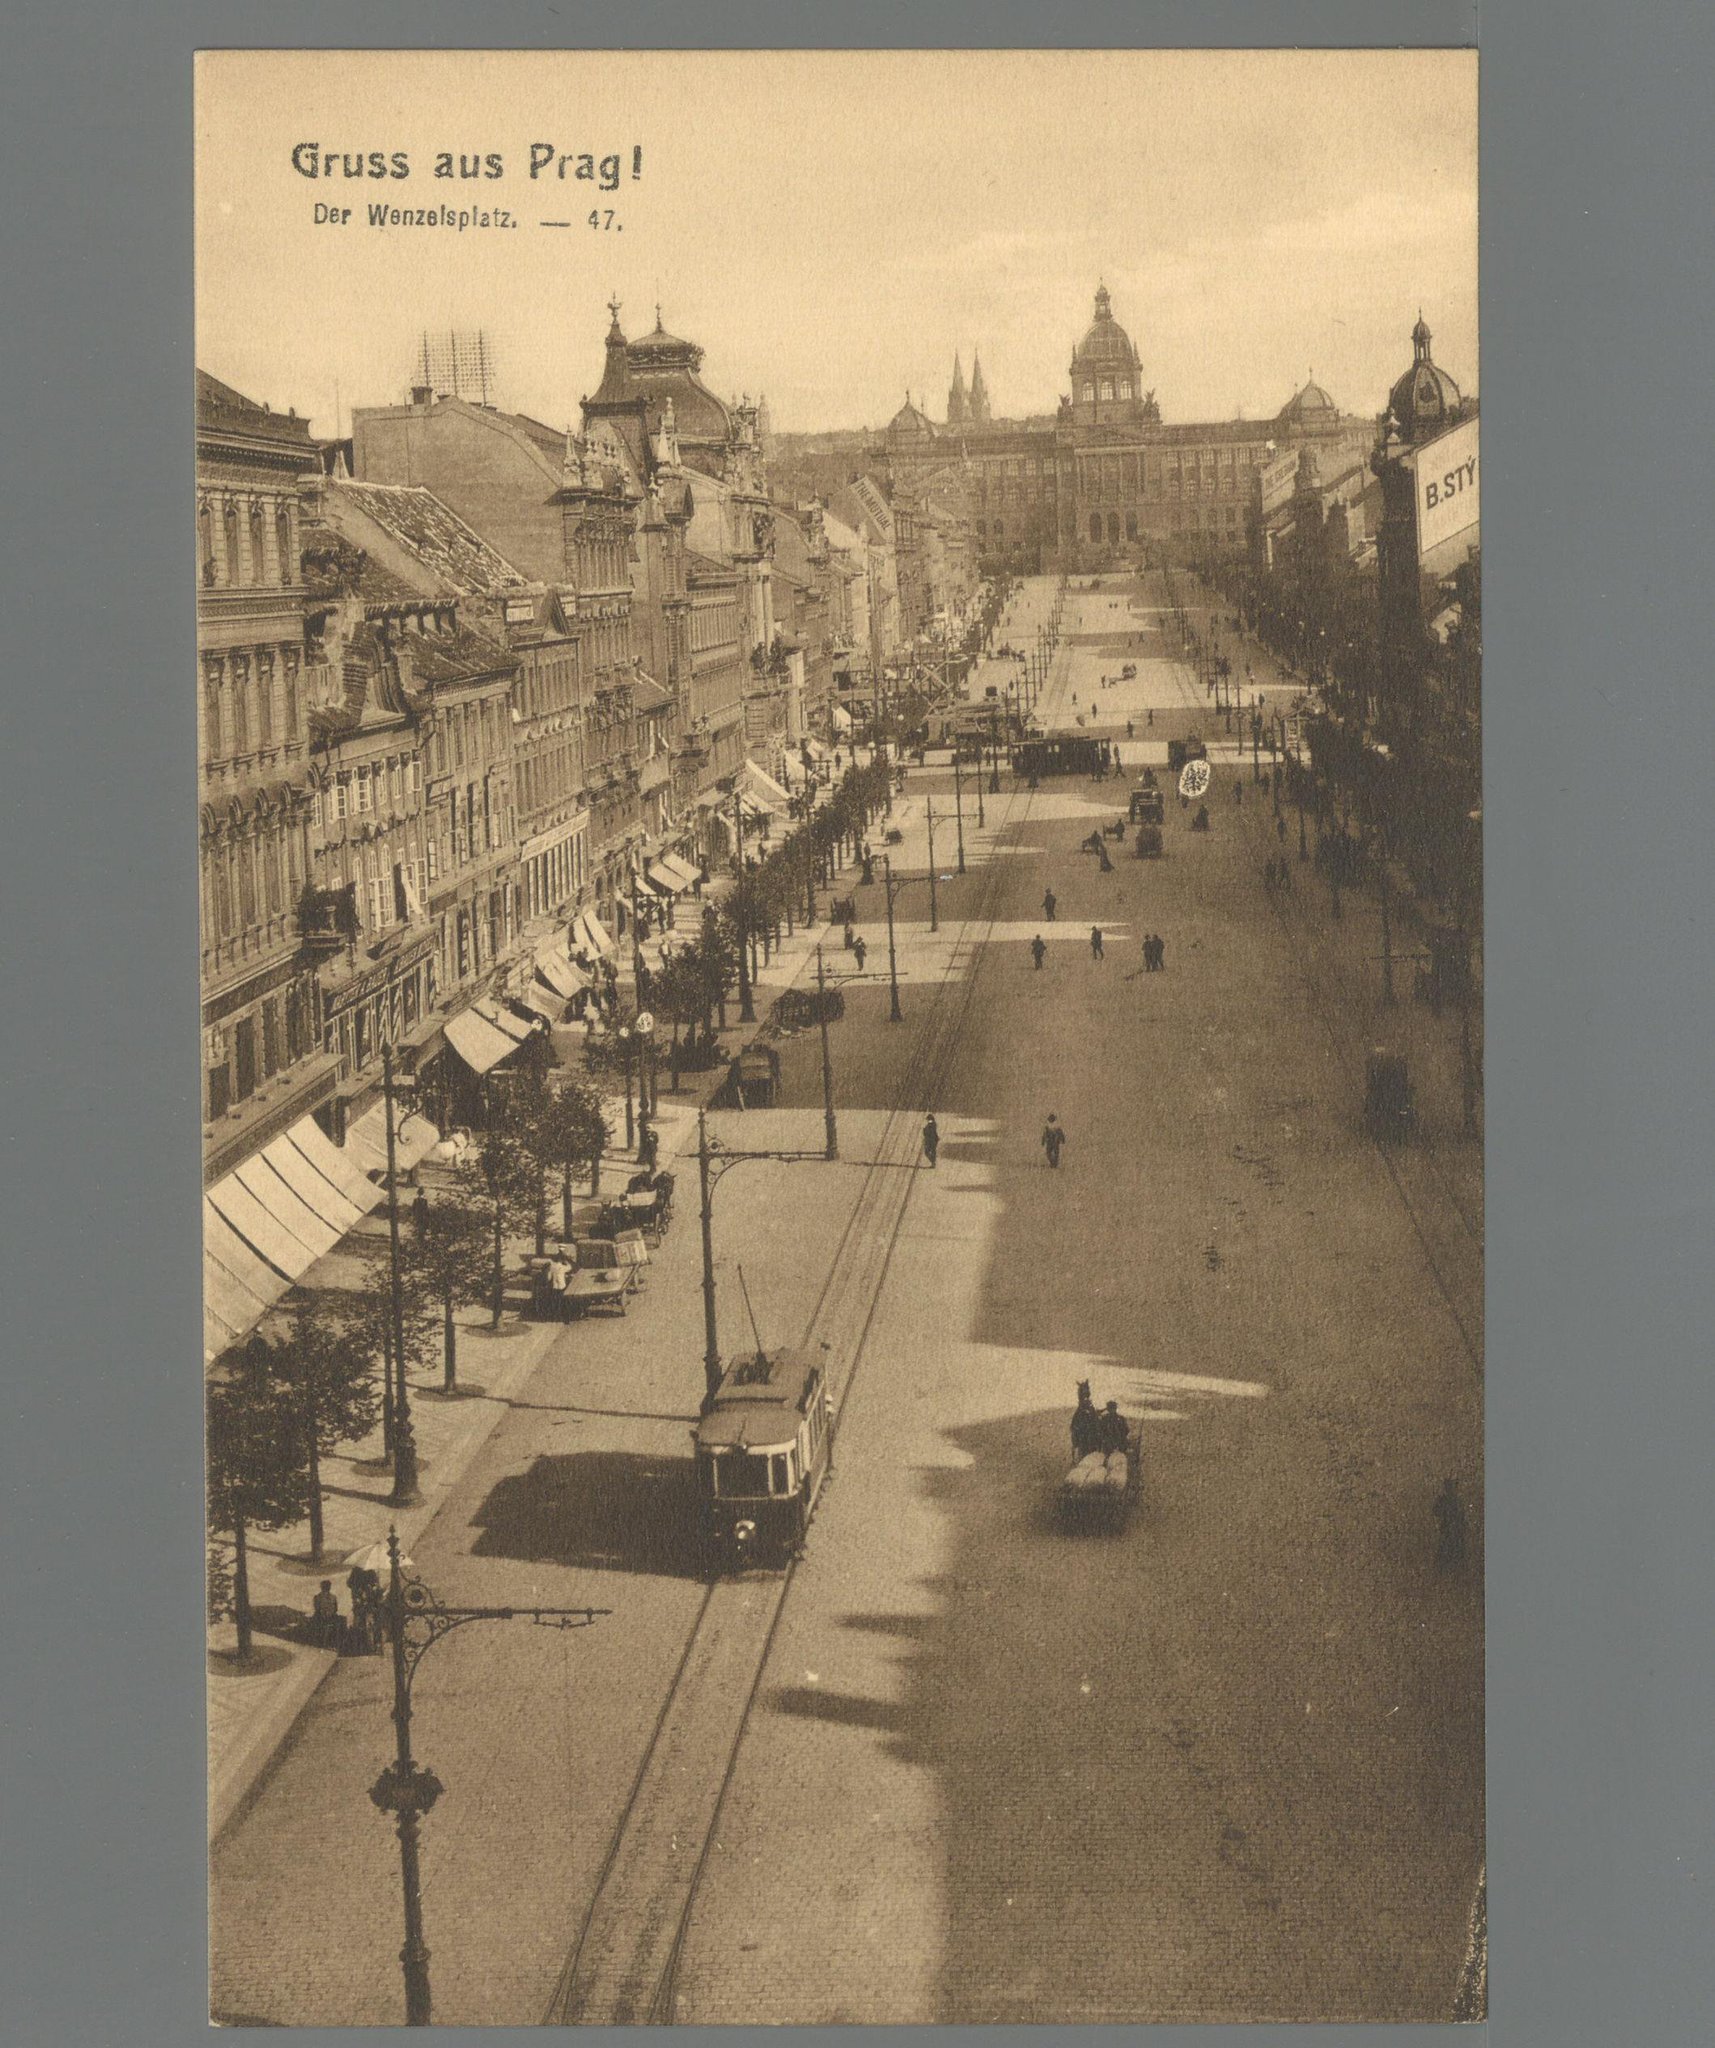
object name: ansichtkaart, prentbriefkaart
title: Gruss aus Prag! Der Wenzelsplatz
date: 1908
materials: cardboard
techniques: photograph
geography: prague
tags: shop, store, street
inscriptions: date